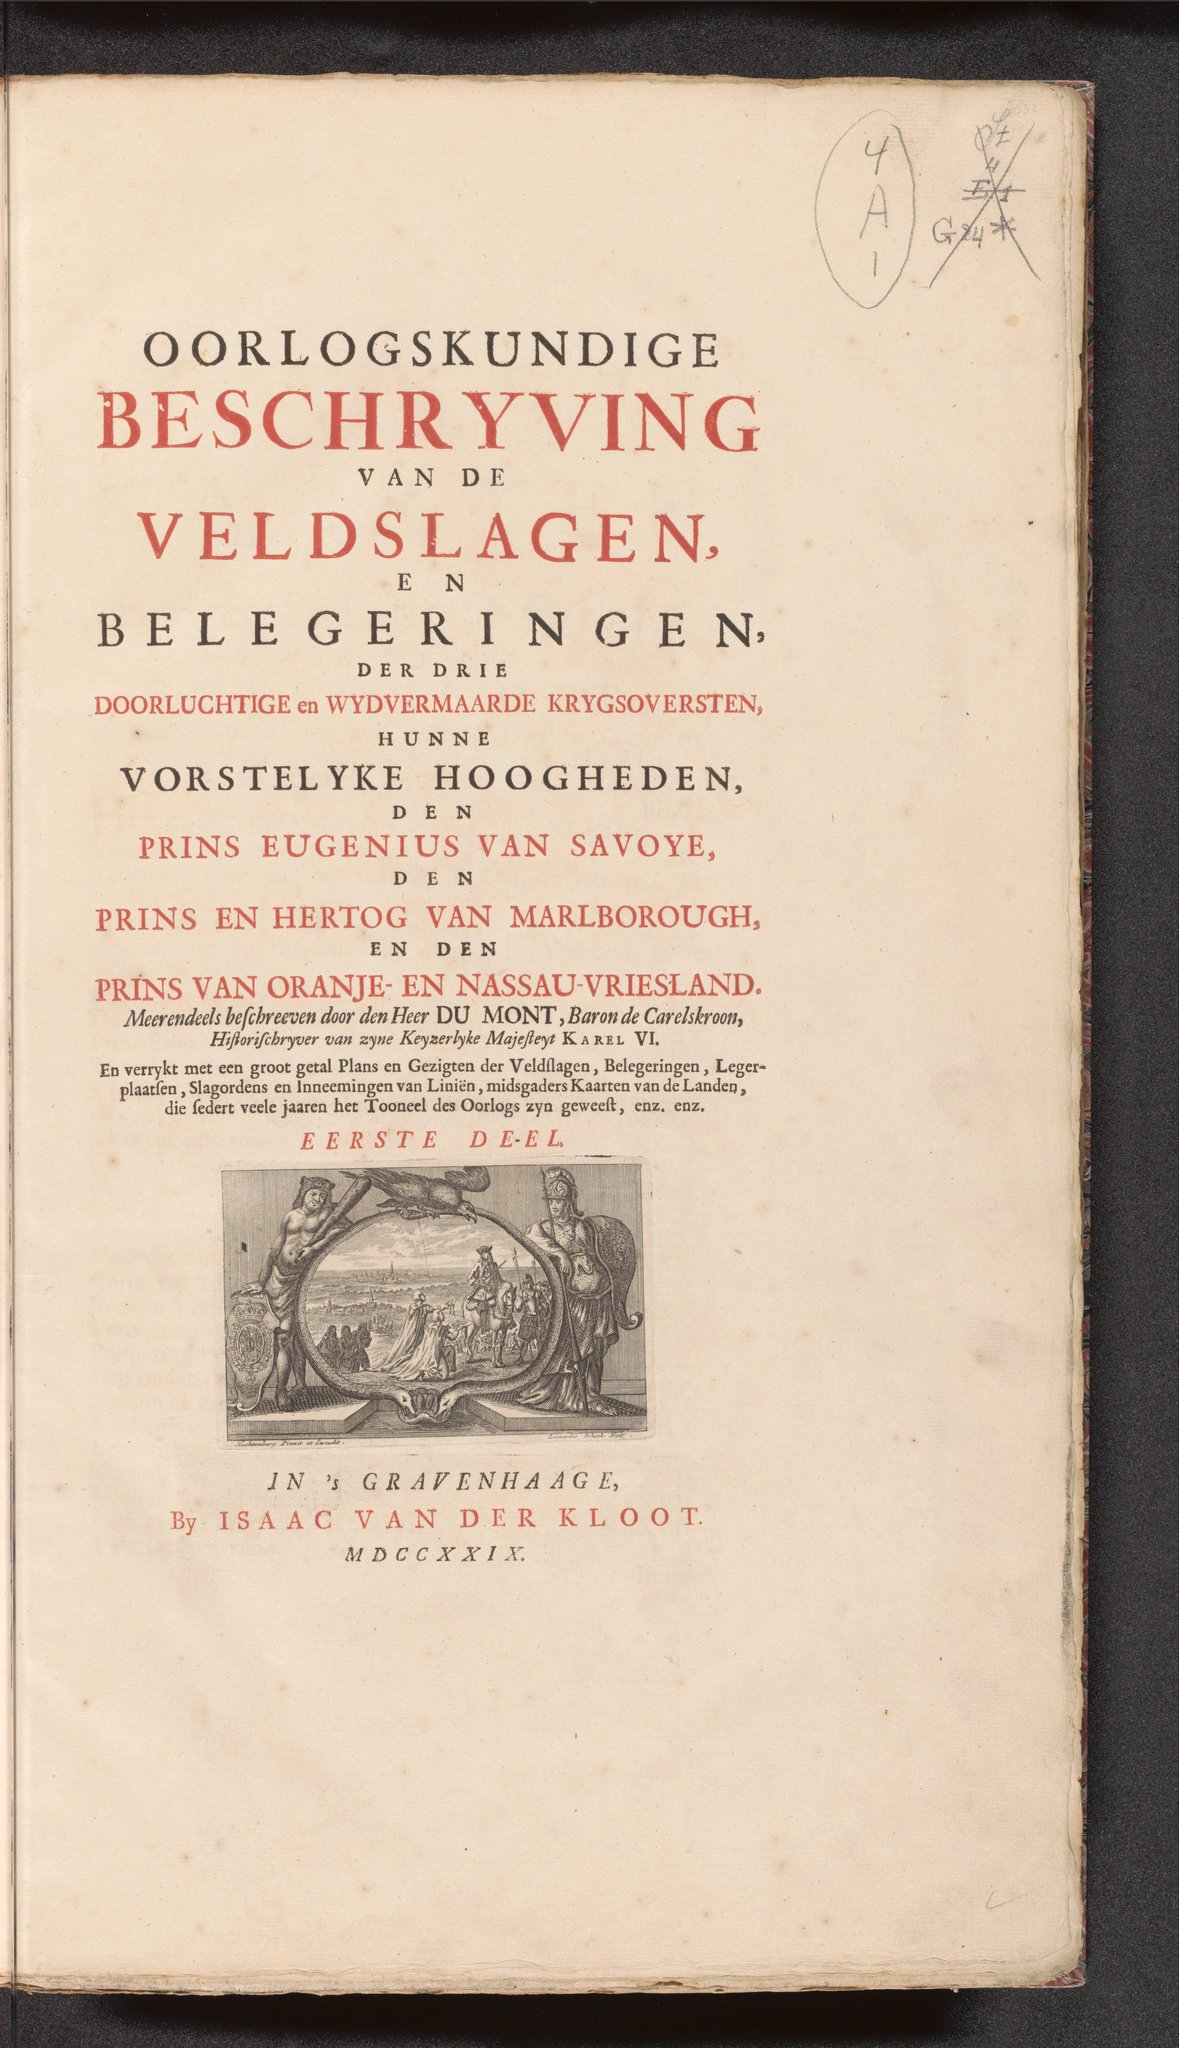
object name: print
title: Titelpagina voor: [Jean] du Mont, Oorlogskundige beschryving van de veldslagen en belegeringen, der drie (...) wydvermaarde krygsoversten(...) den Prins Eugenius van Savoye, den (...) Hertog van Marlborough, en den Prins van Oranje en Nassau-Vriesland, Eerste Deel, 's-Gravenhage 1729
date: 1729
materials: paper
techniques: etching, letterpress printing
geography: northern netherlands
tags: vienna, eugenius van savoye, surrender of keys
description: Titelpagina voor: [Jean] du Mont, Oorlogskundige beschryving van de veldslagen en belegeringen, der drie ... wydvermaarde krygsoversten... den Prins Eugenius van Savoye, den ... Hertog van Marlborough, en den Prins van Oranje en Nassau-Vriesland, Eerste Deel, 's-Gravenhage 1729. Blad met de titel in boekdruk in rood en zwart met een vignet waarop een veldheer de sleutels van een overwonnen stad aangeboden krijgt, in omlijsting van slangen, Hercules en Minerva. Dit eerste deel is gewijd aan de daden van Eugenius, prins van Savoye.